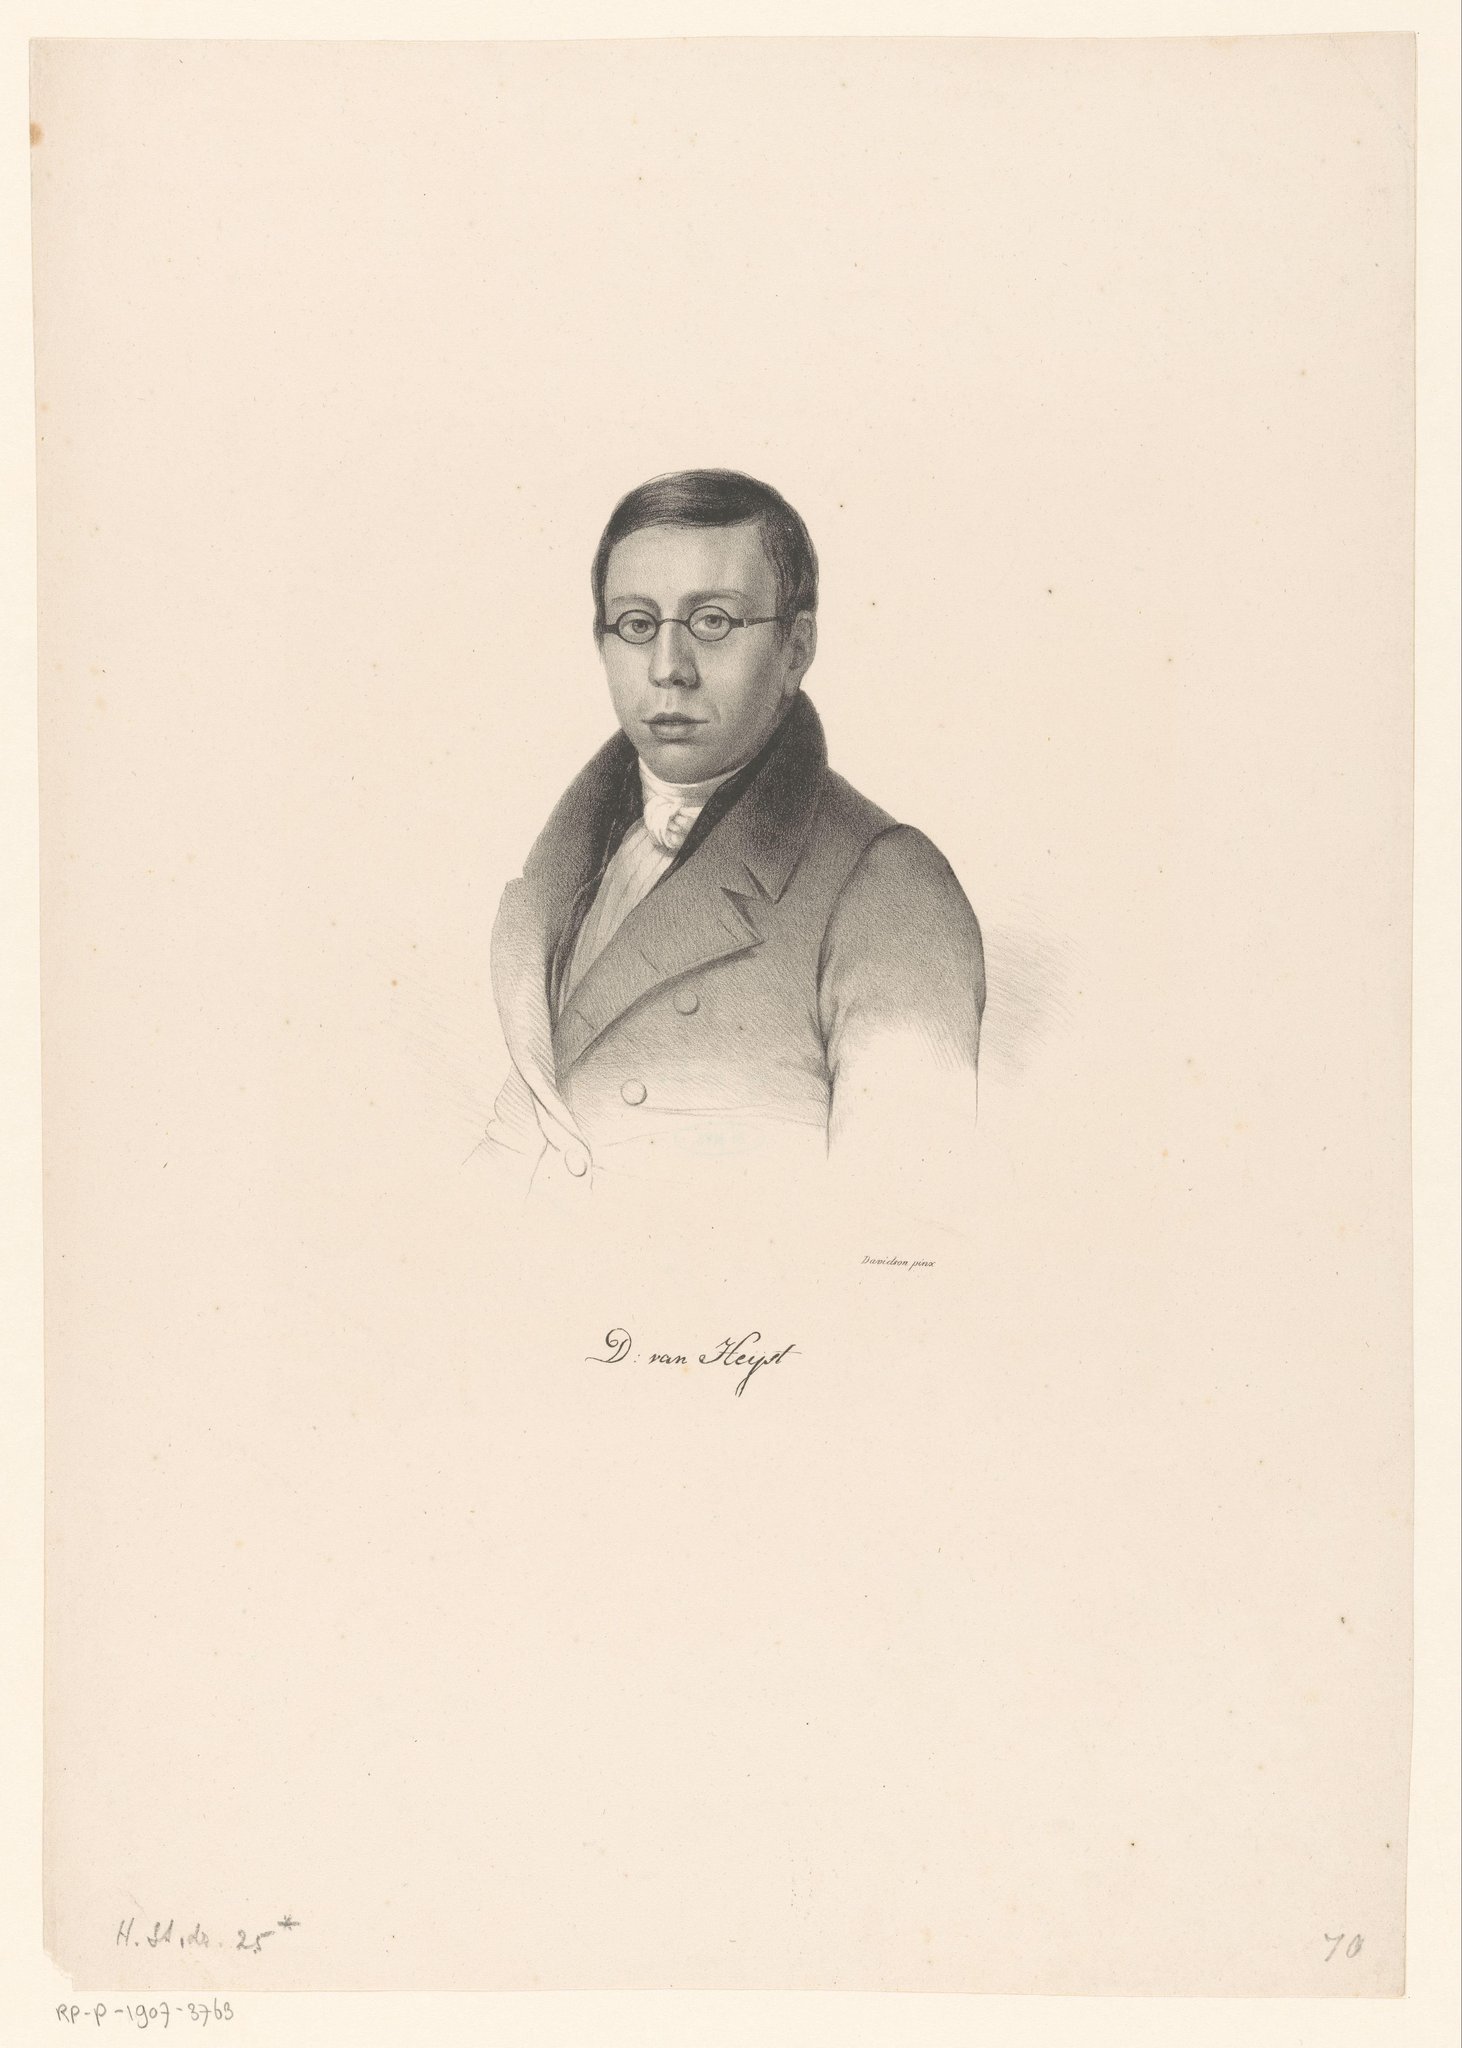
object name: print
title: Portret van David van Heyst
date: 1817-1836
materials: paper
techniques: lithograph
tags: amsterdam, eyeglasses, spectacles, historical persons (+ (full) bust portrait)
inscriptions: collector's mark: Lugt 2228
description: De geportretteerde draagt een bril. Onder het portret zijn signatuur.